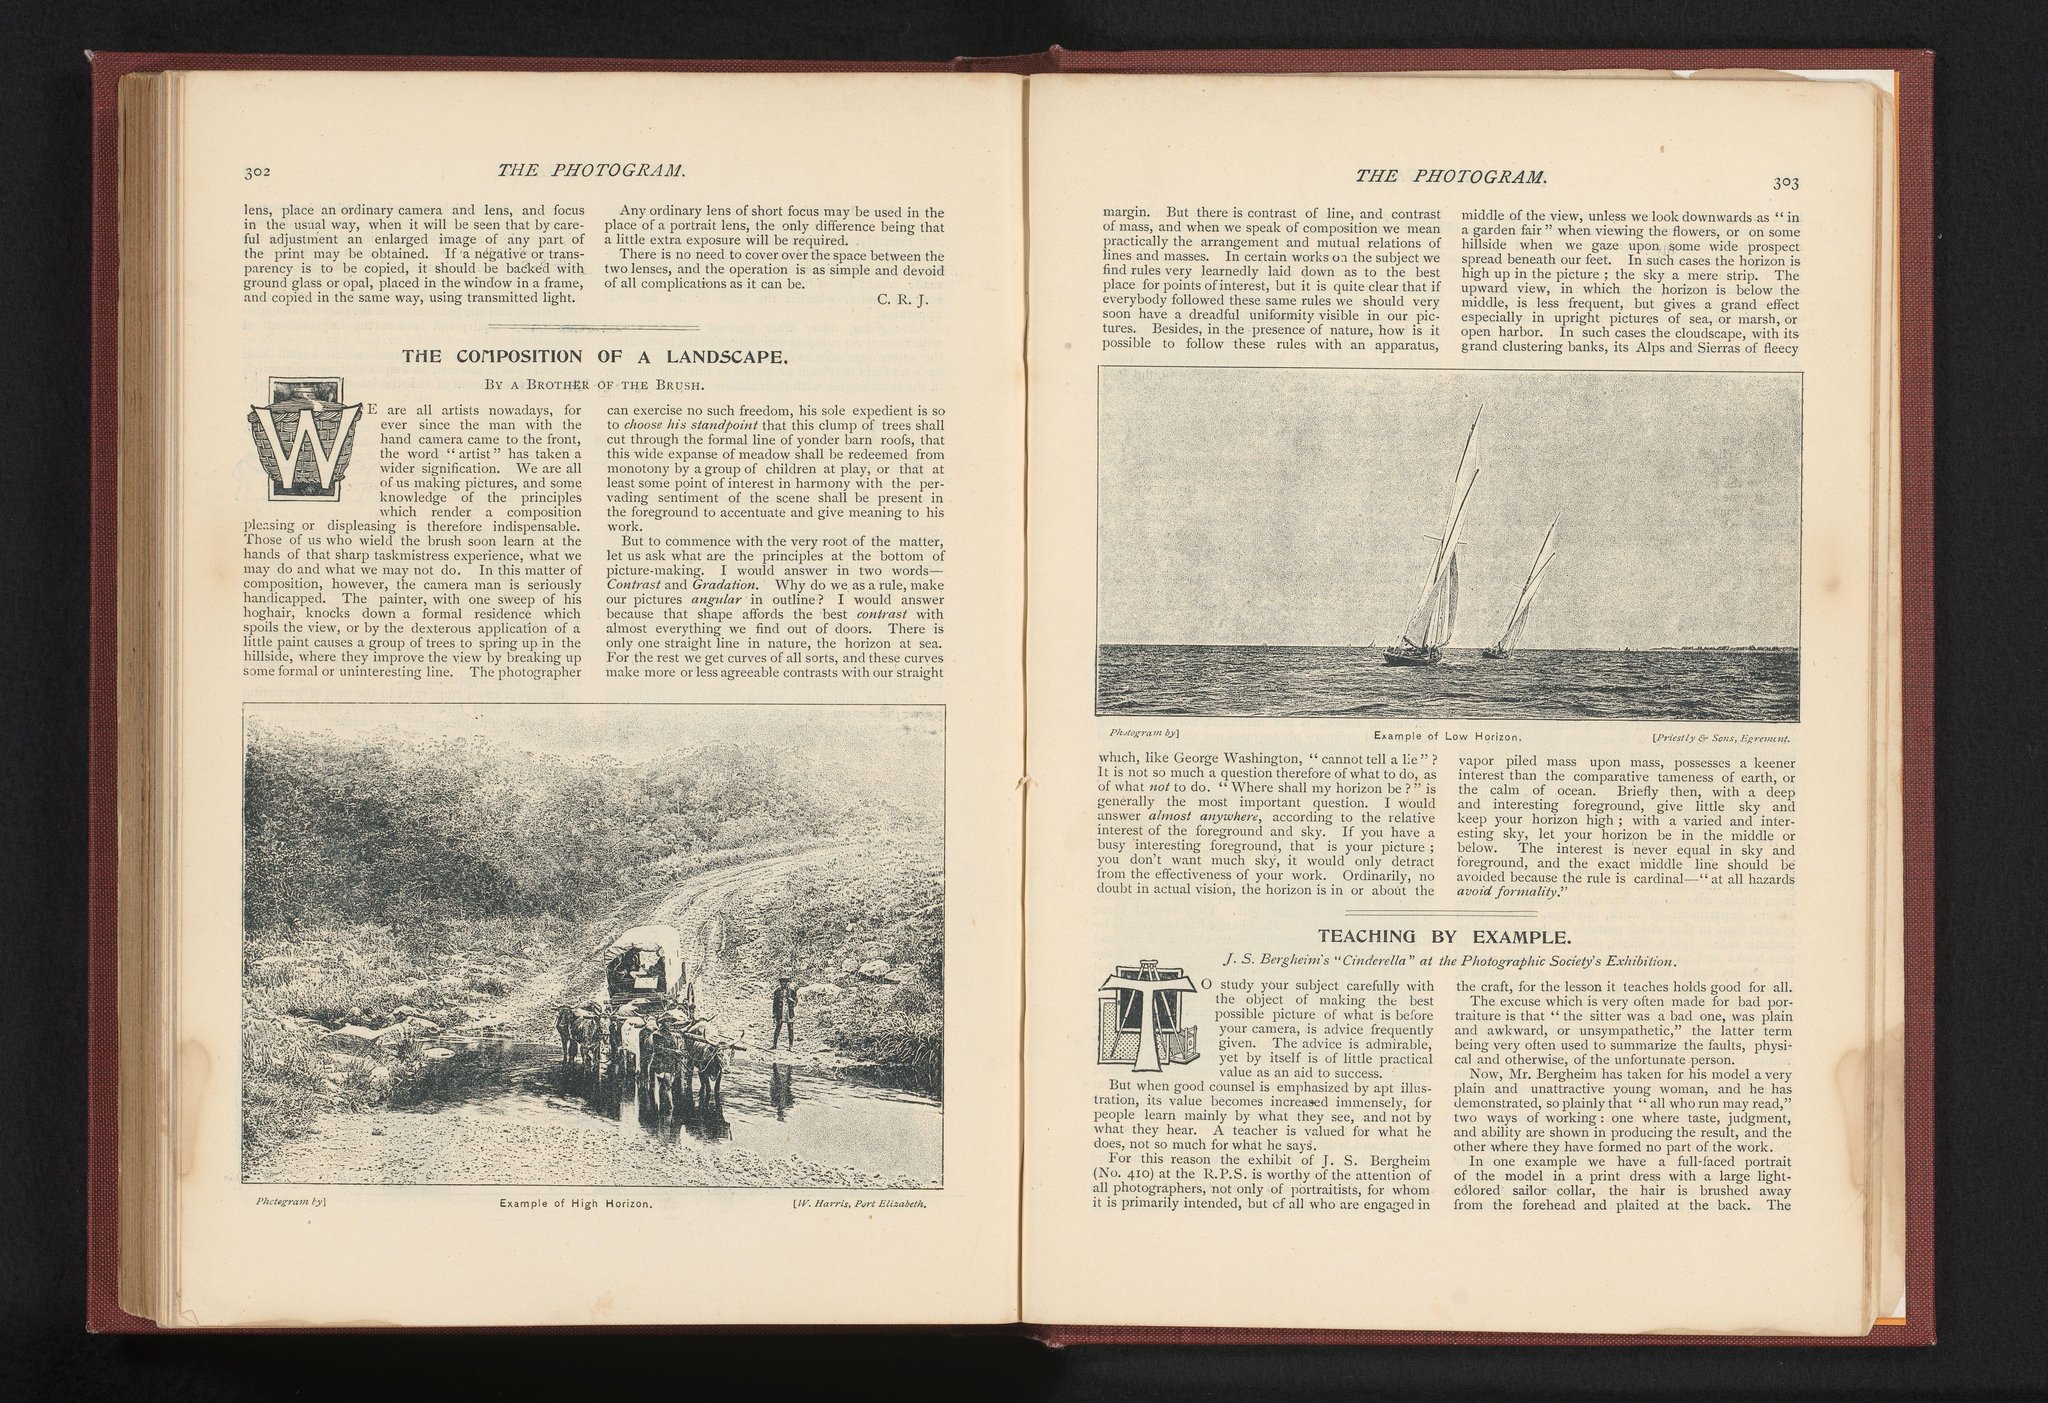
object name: page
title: Example of high horizon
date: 1889-1894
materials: paper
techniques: autotype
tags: river, ox, four-wheeled vehicle drawn by more than three animals